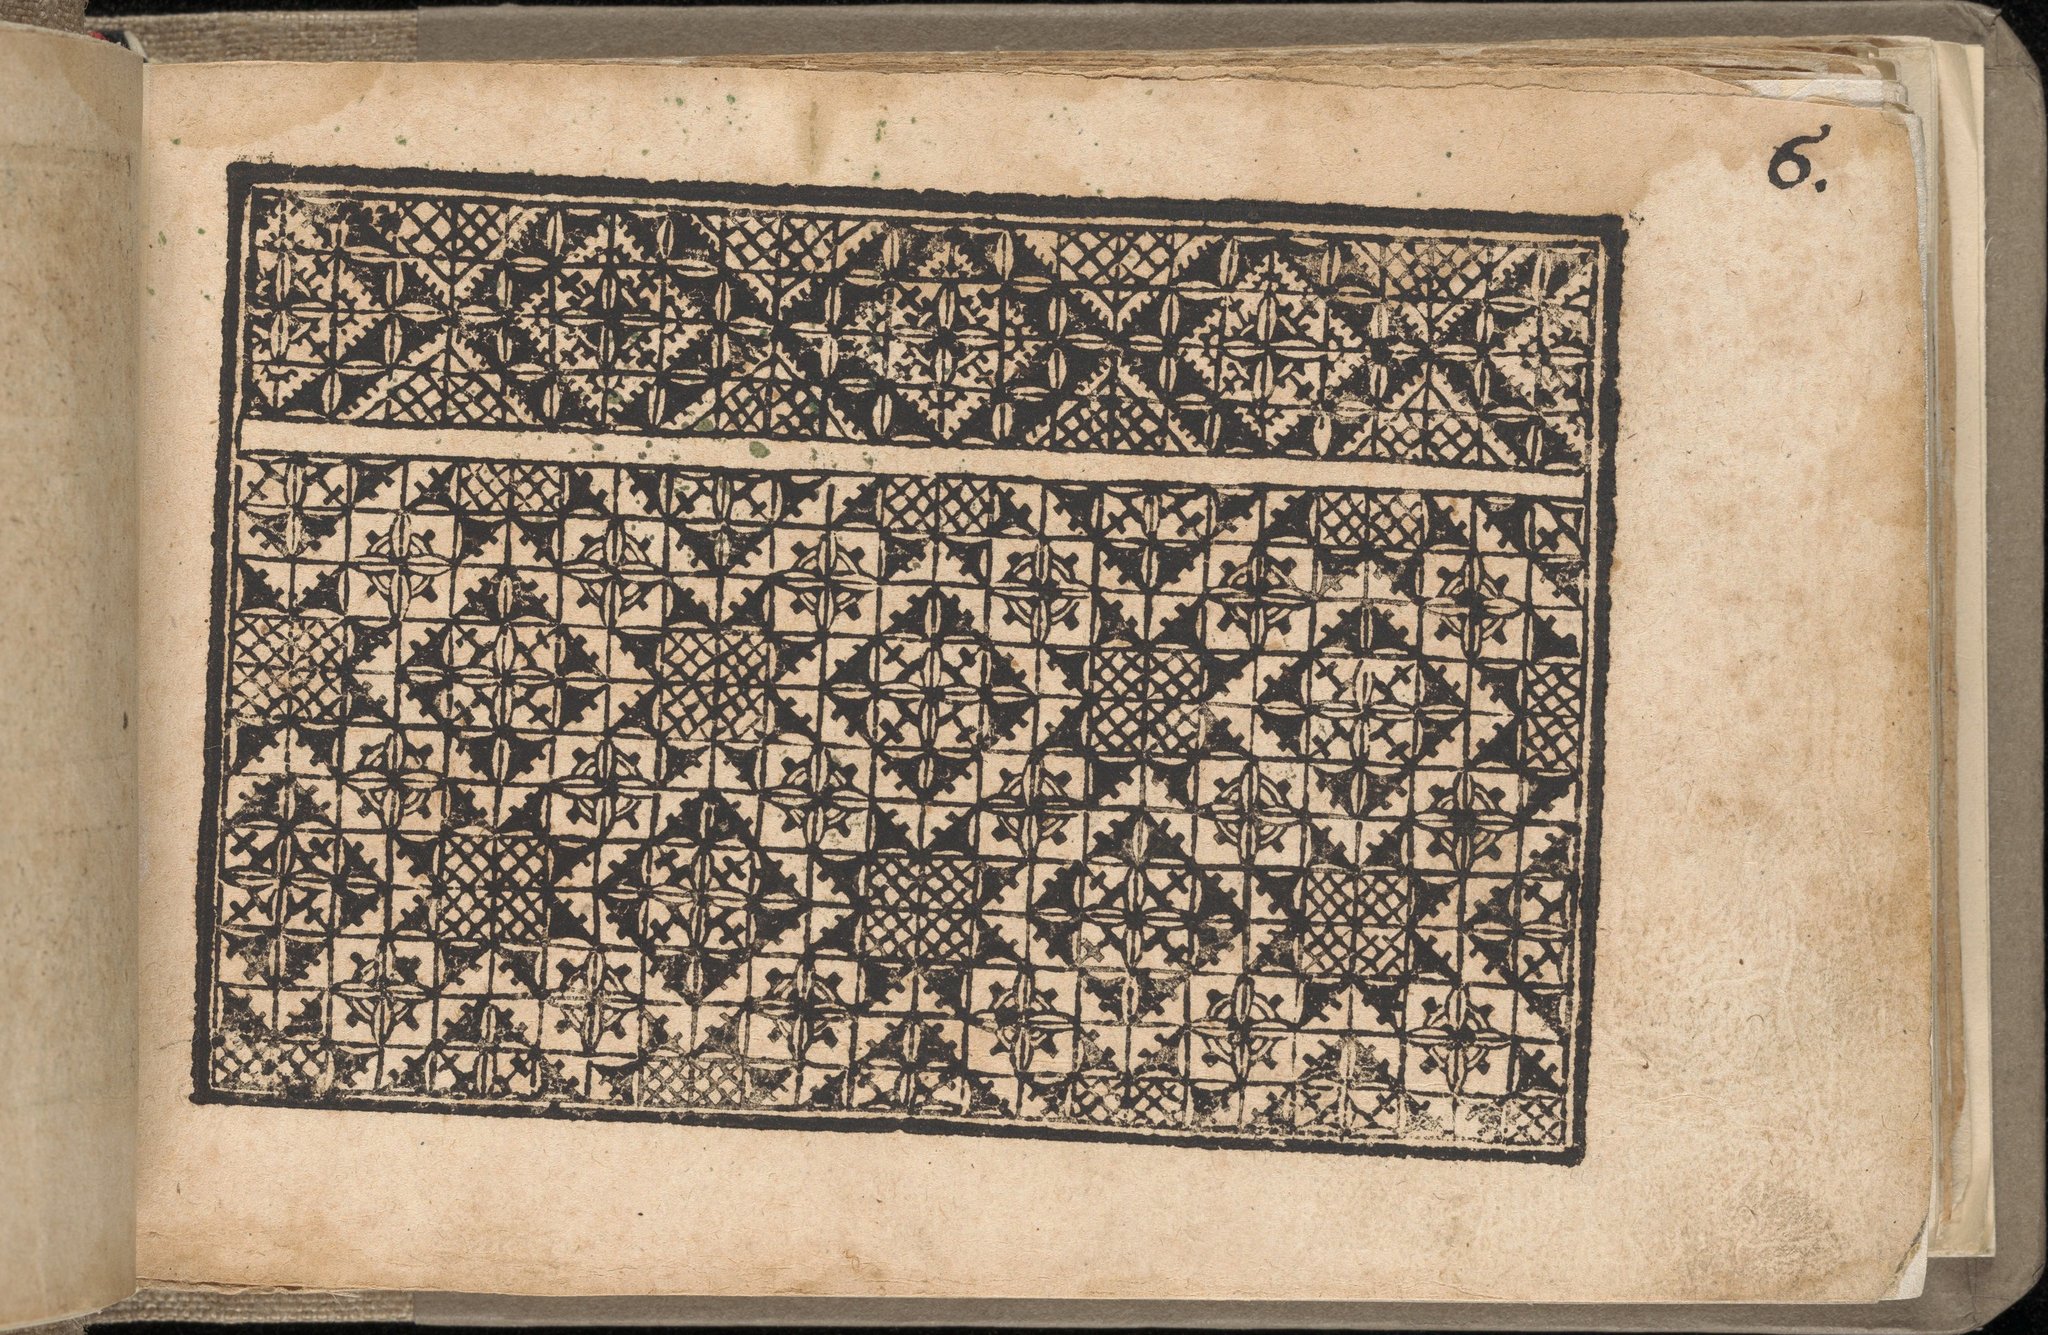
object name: book print ornament architecture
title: Schön newes Modelbuch (Page 6r)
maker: sigismundus latomus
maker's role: publisher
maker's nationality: german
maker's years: 1599-1632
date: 1608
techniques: woodcut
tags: ornament